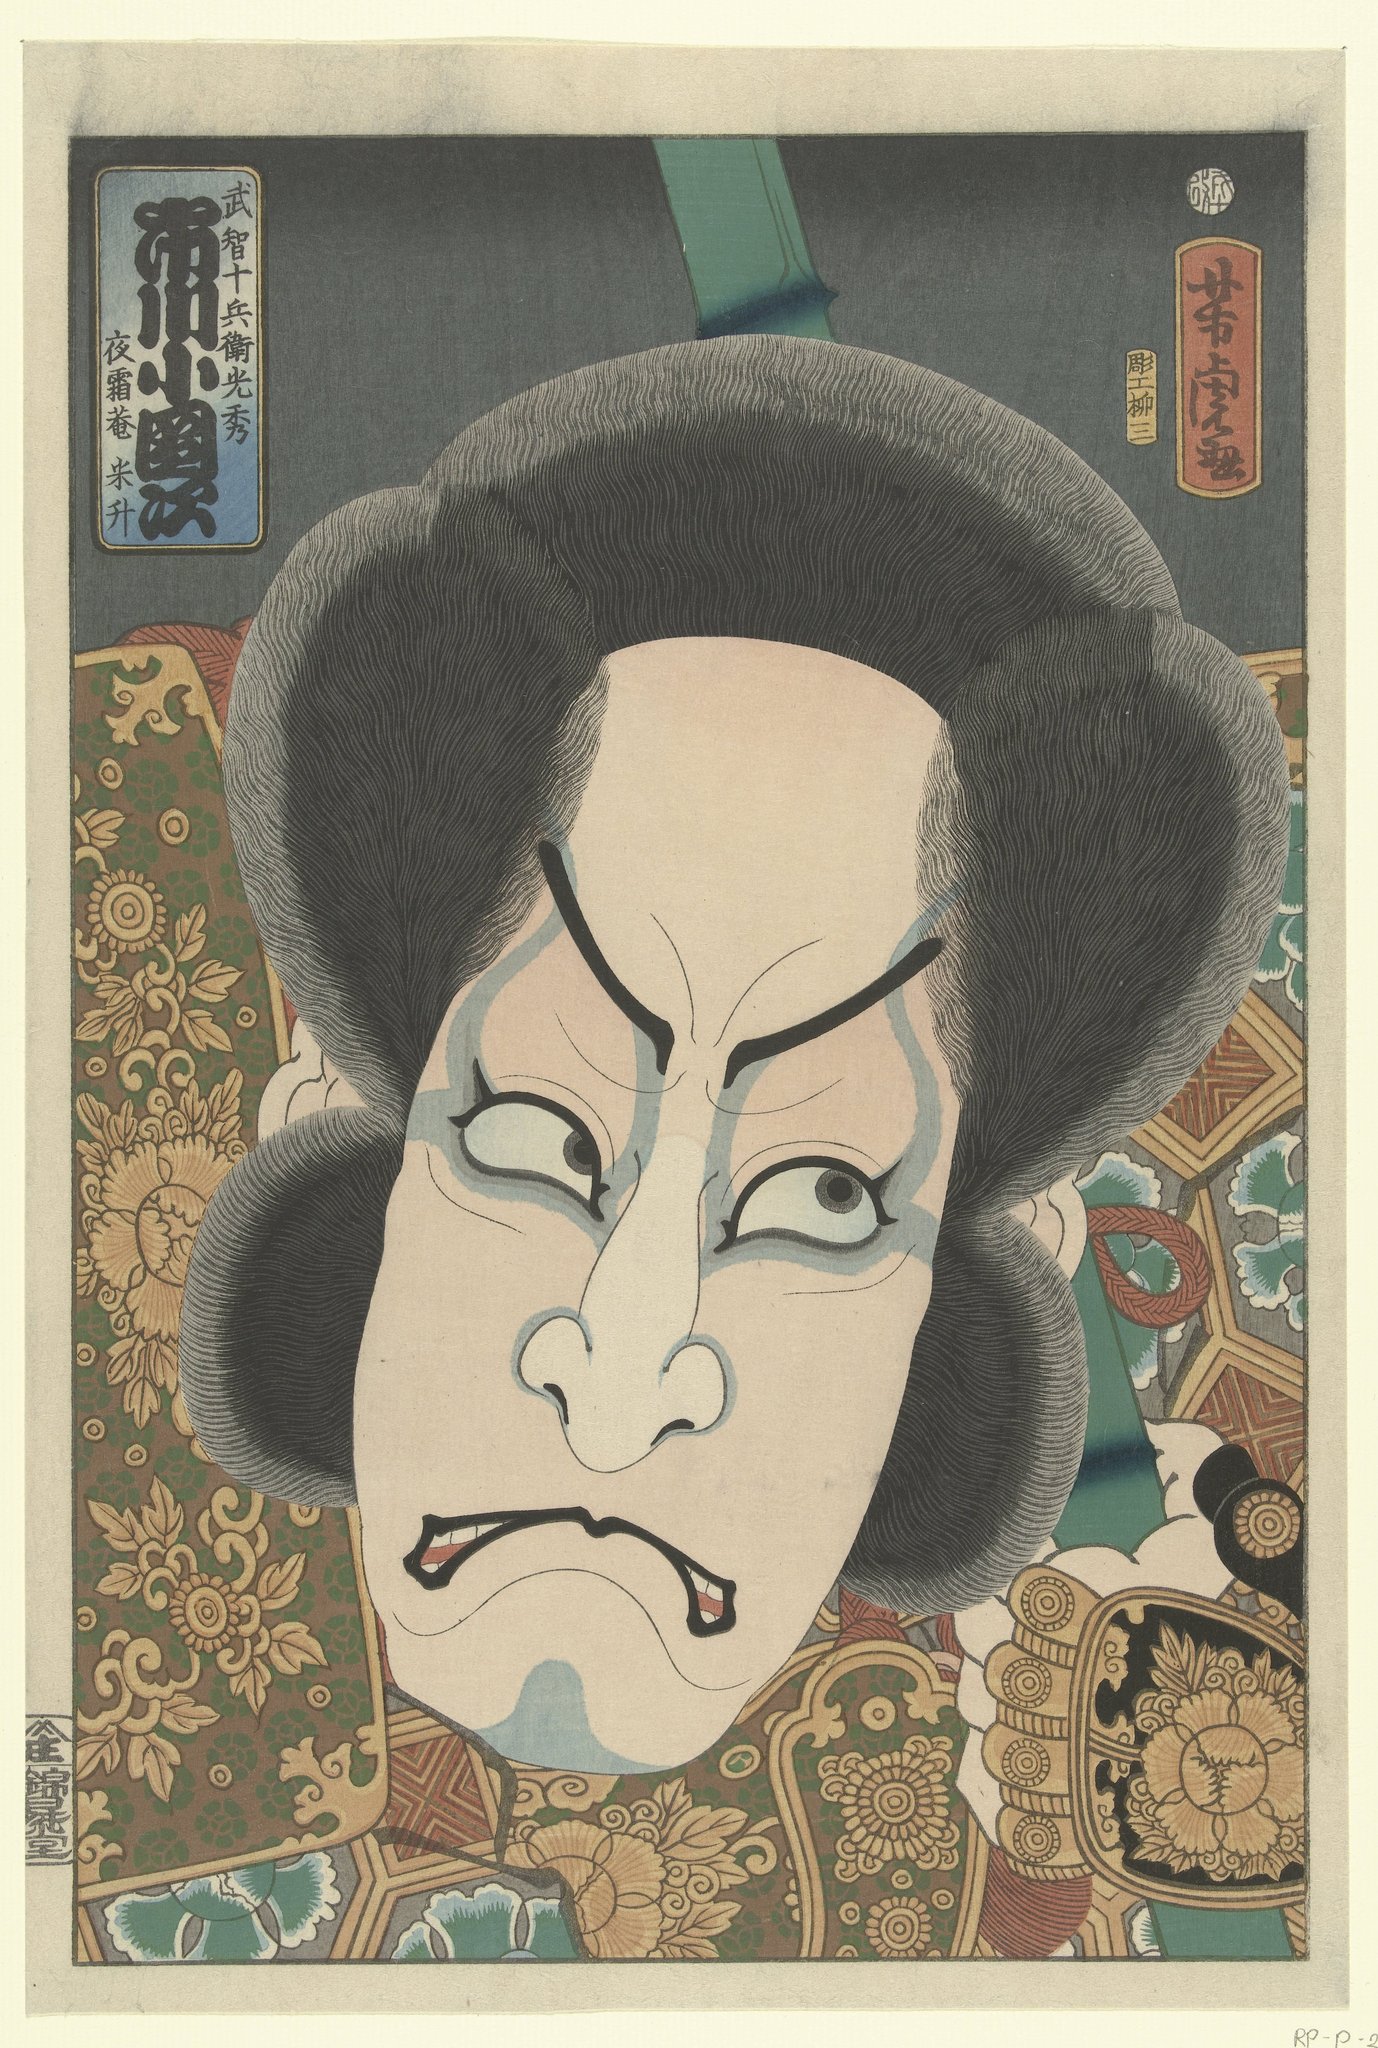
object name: print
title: Ichikawa Kodanji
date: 1802-1862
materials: paper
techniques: woodcut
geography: tokyo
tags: actor (on the stage)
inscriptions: date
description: Portret van de acteur Ichikawa Kodanji IV in de rol van Takechi Mitsuhide; in zijn linker hand een bamboe speer.